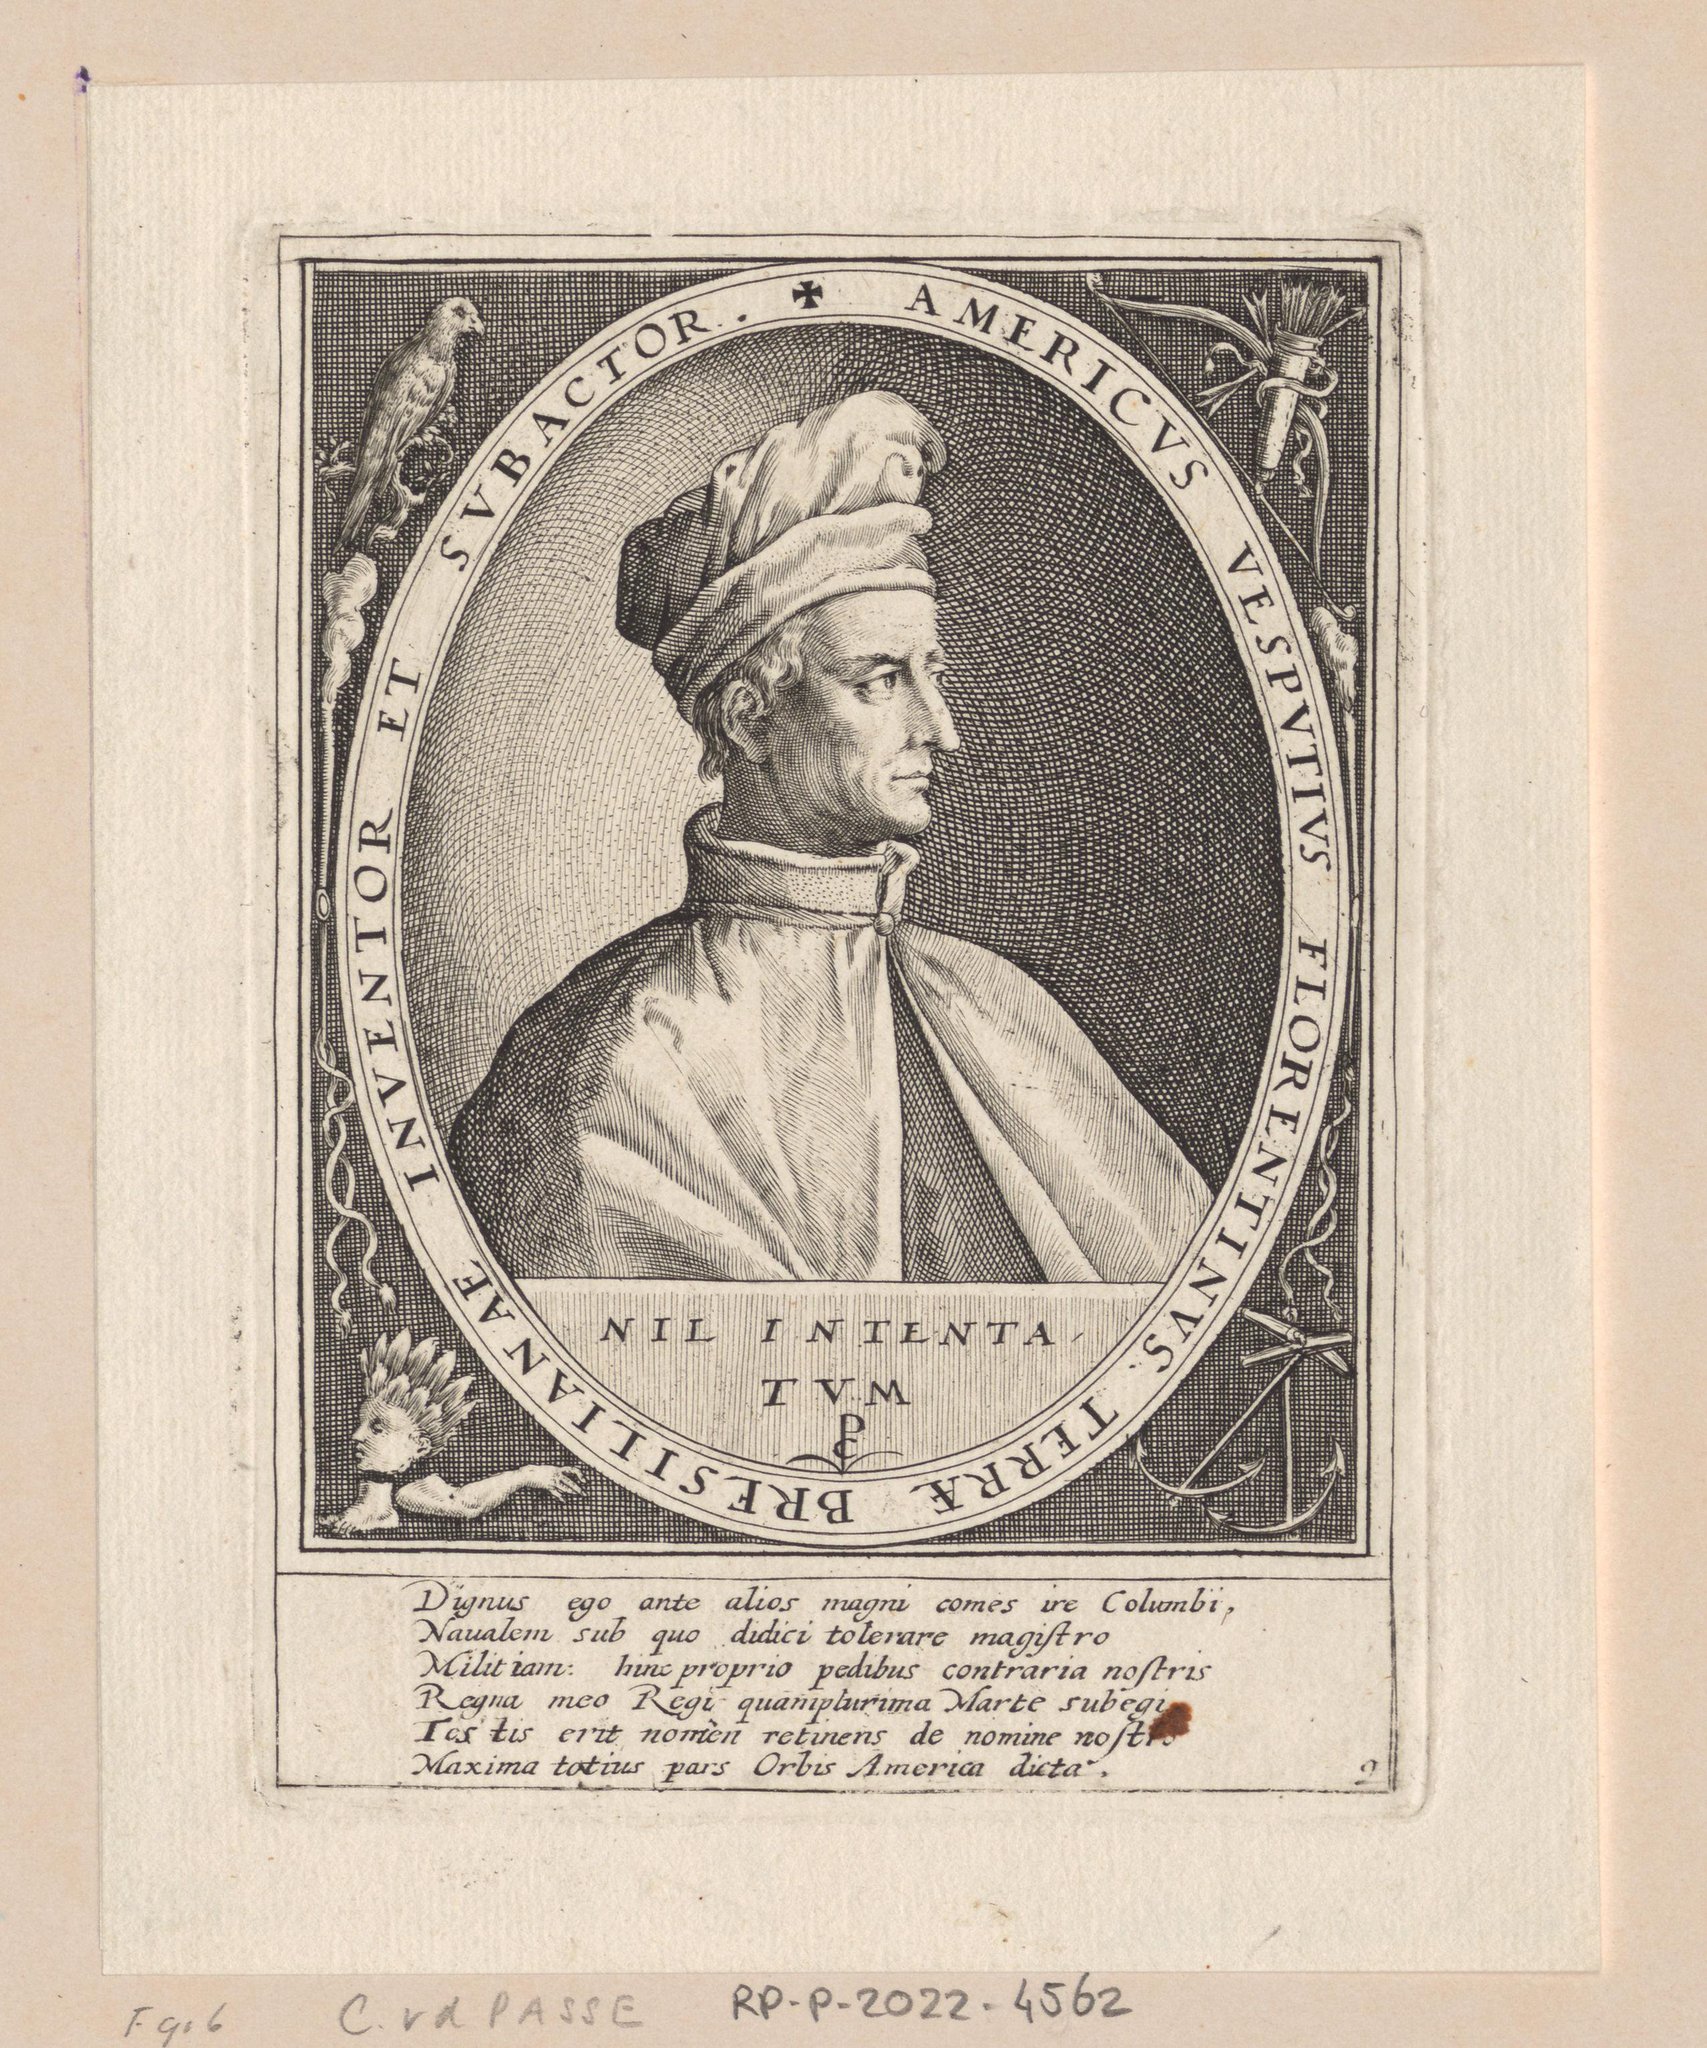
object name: print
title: Portret van Amerigo Vespucci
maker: crispijn van de passe (i)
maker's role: draughtsman, print maker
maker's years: 1564-1637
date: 1598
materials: paper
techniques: engraving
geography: cologne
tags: sevilla, historical persons, explorer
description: Met zesregelig onderschrift in het Latijn. Rechtsonder genummerd: 9.